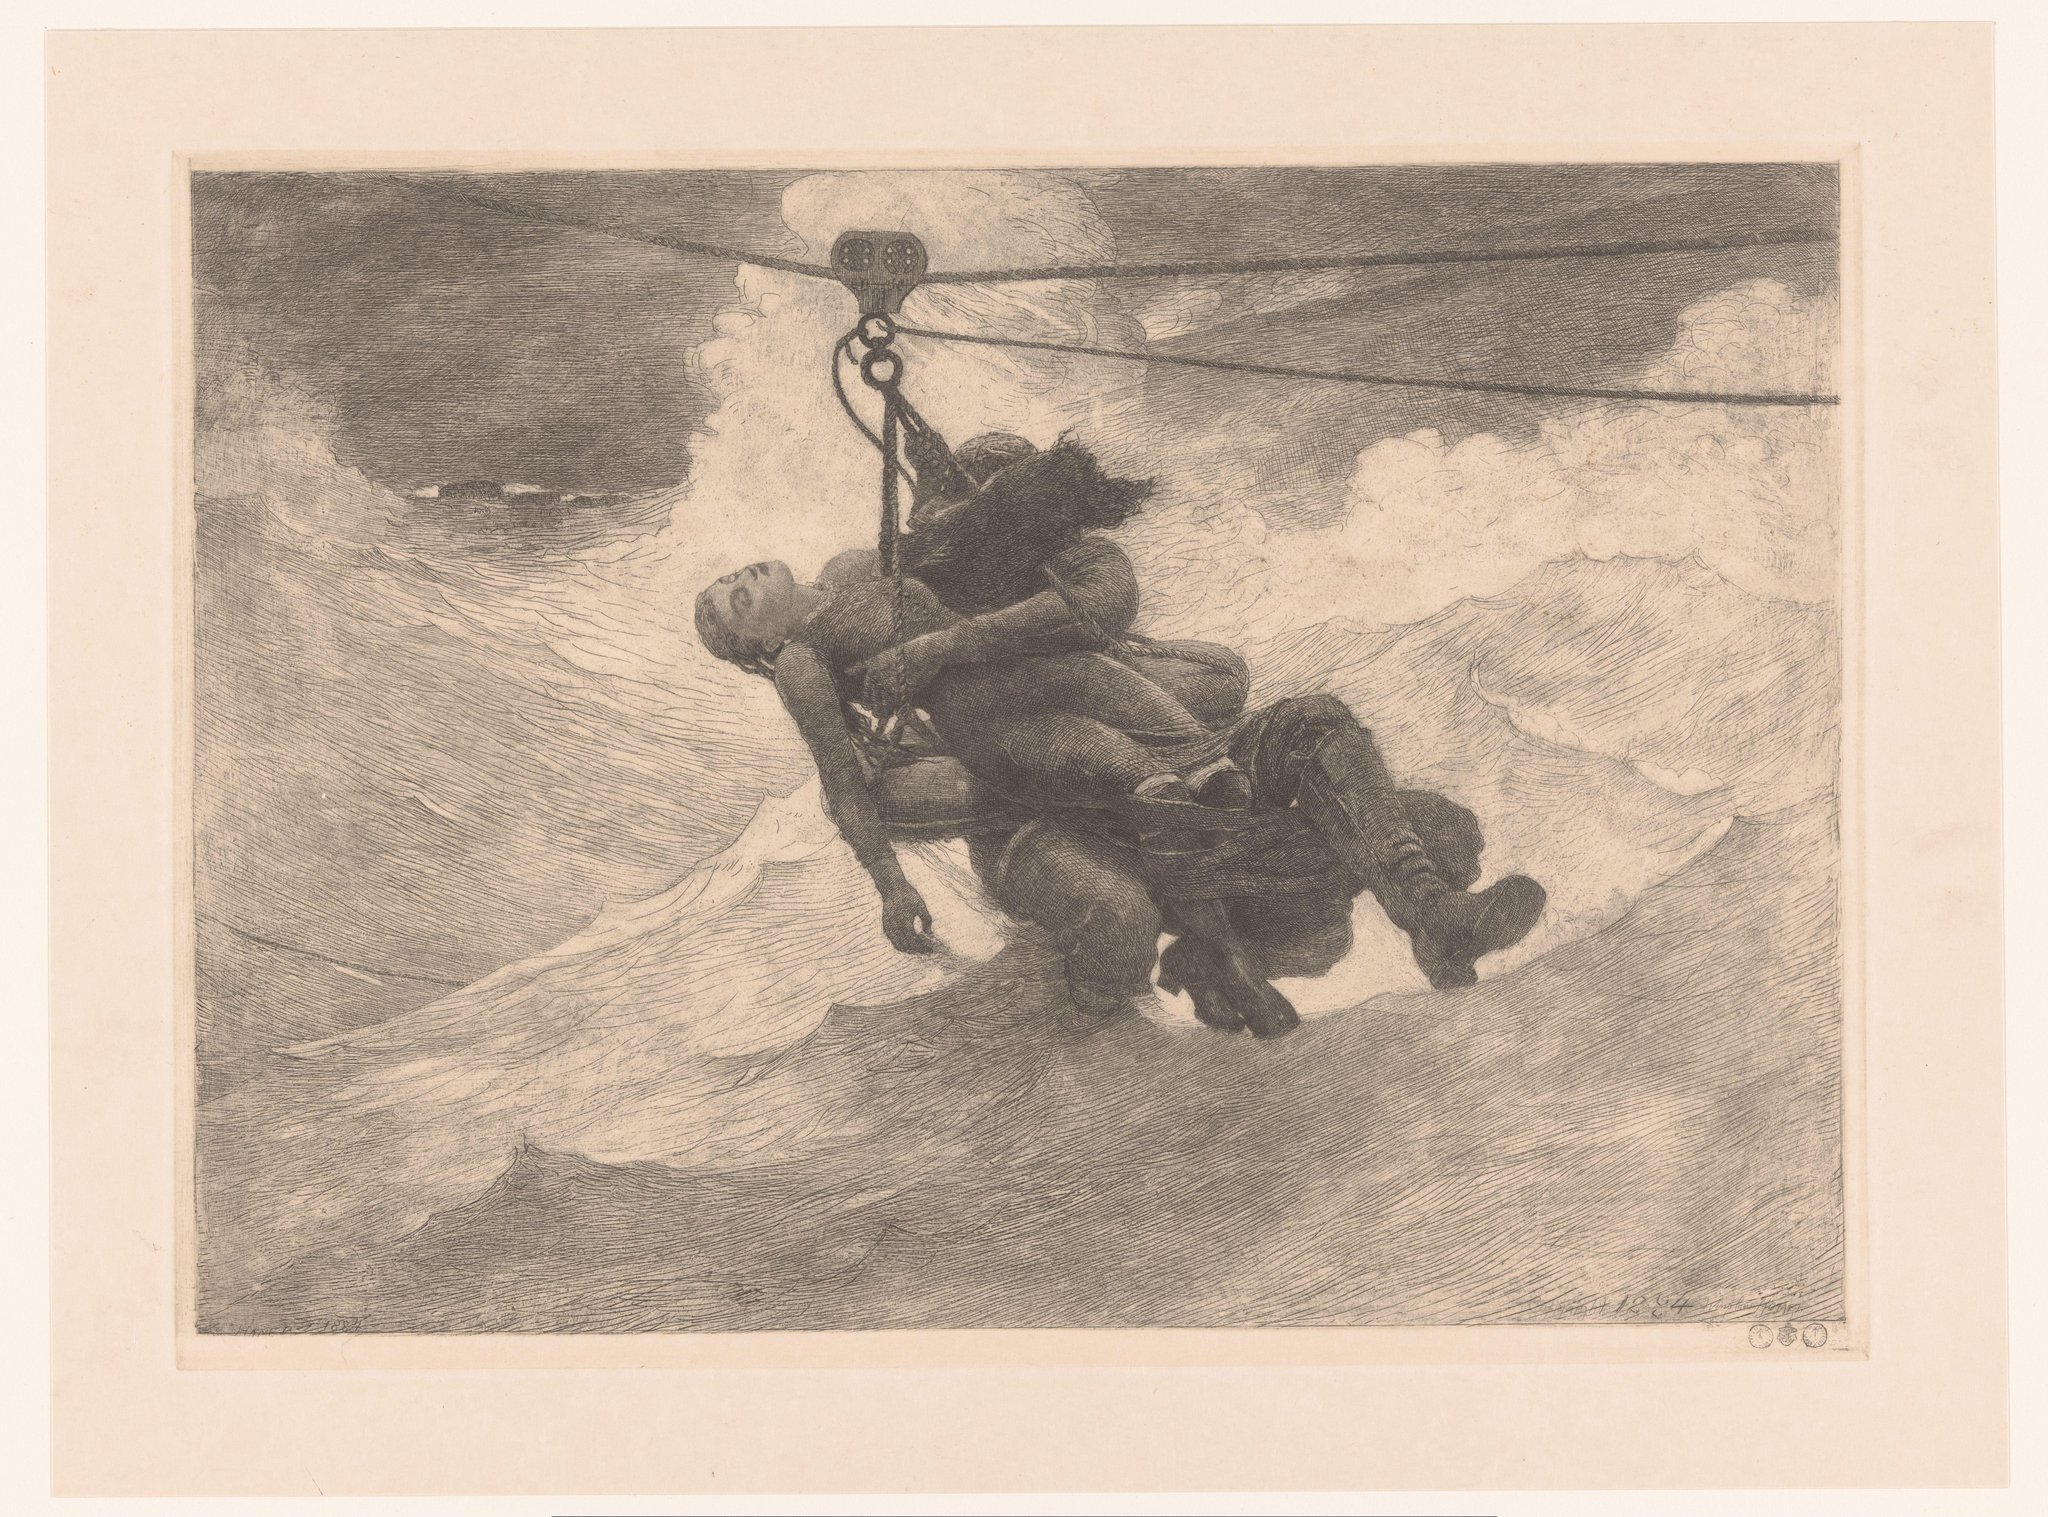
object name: print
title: The life line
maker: winslow homer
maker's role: painter, print maker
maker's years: 1836-1910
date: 1884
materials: paper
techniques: etching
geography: united states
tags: drowning, shipwrecked person, saving a person from drowning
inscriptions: collector's mark: Lugt 2228, address: ‘The Life Line / Printed from Winslow Homer's / Original Etched Plate / The Metropoitan Museum of Art’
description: Een vrouw wordt door een man van een reddingsbrigade met een lijn uit het water gehaald.